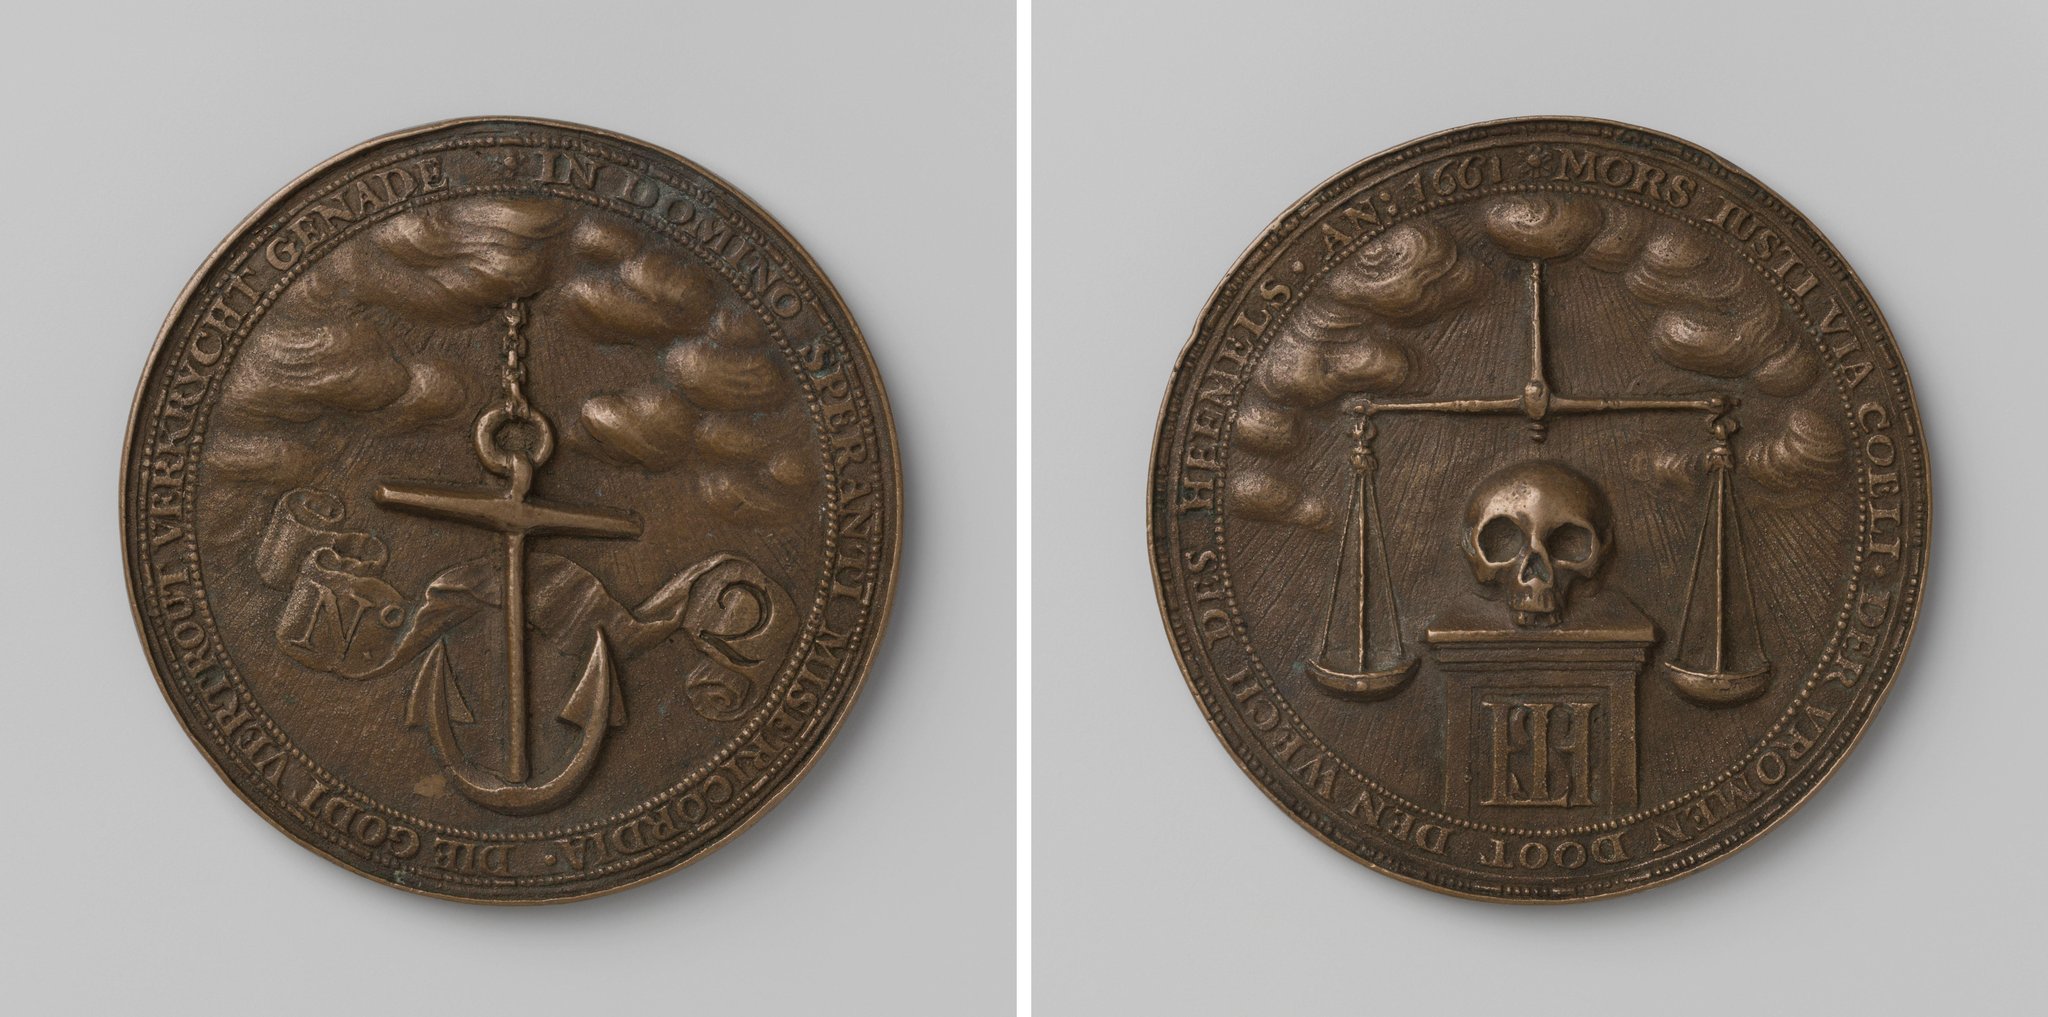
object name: funeral token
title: Kramersgilde [?], begrafenispenning met no. 2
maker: Anonymous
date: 1661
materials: brass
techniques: casting, engraving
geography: netherlands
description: Messing penning. Voorzijde: anker uit hemel, beschenen door hemellicht; daarachter wimpel met No. 2 binnen omschrift. Keerzijde: in evenwicht hangende balans, beschenen door hemellicht, boven altaar, waarop doodshoofd ligt en waarvan zijde monogram van letters H, S en L draagt binnen omschrift.